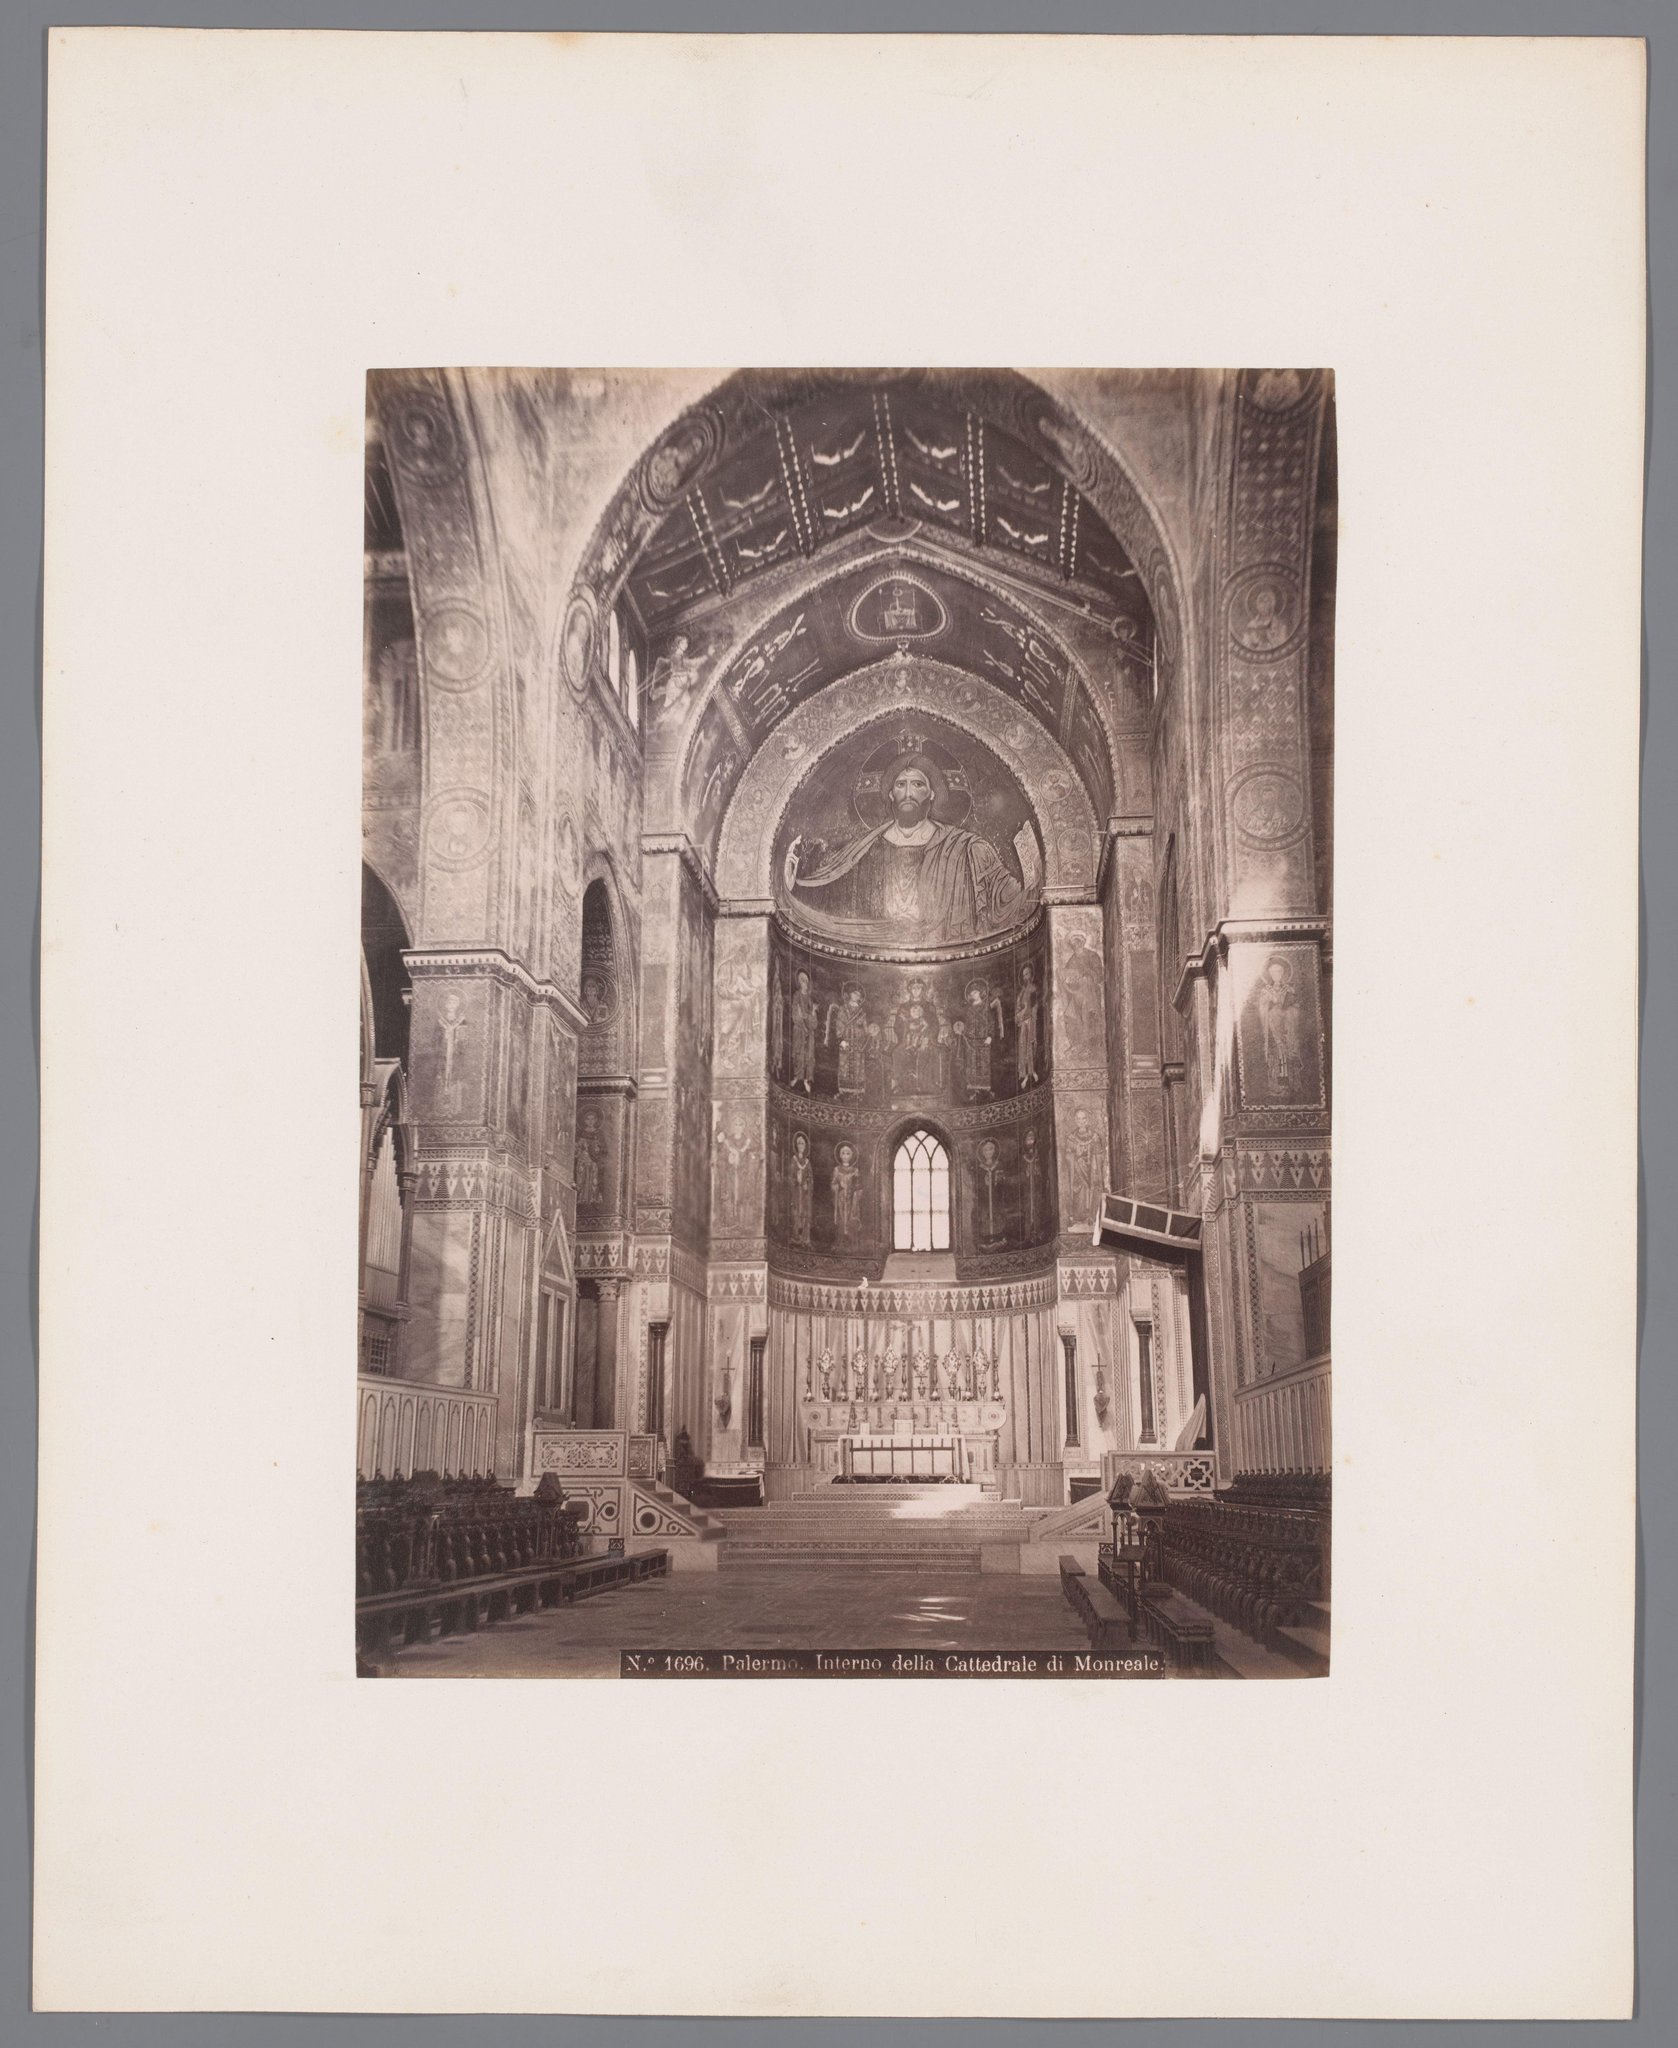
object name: photograph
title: Palermo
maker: roberto rive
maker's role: fotograaf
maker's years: 1825-1868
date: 1860-1889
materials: cardboard, paper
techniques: albumen print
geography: palermo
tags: interior of church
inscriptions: inscription: ‘Rive (t)’, number: ‘No. 1696.’